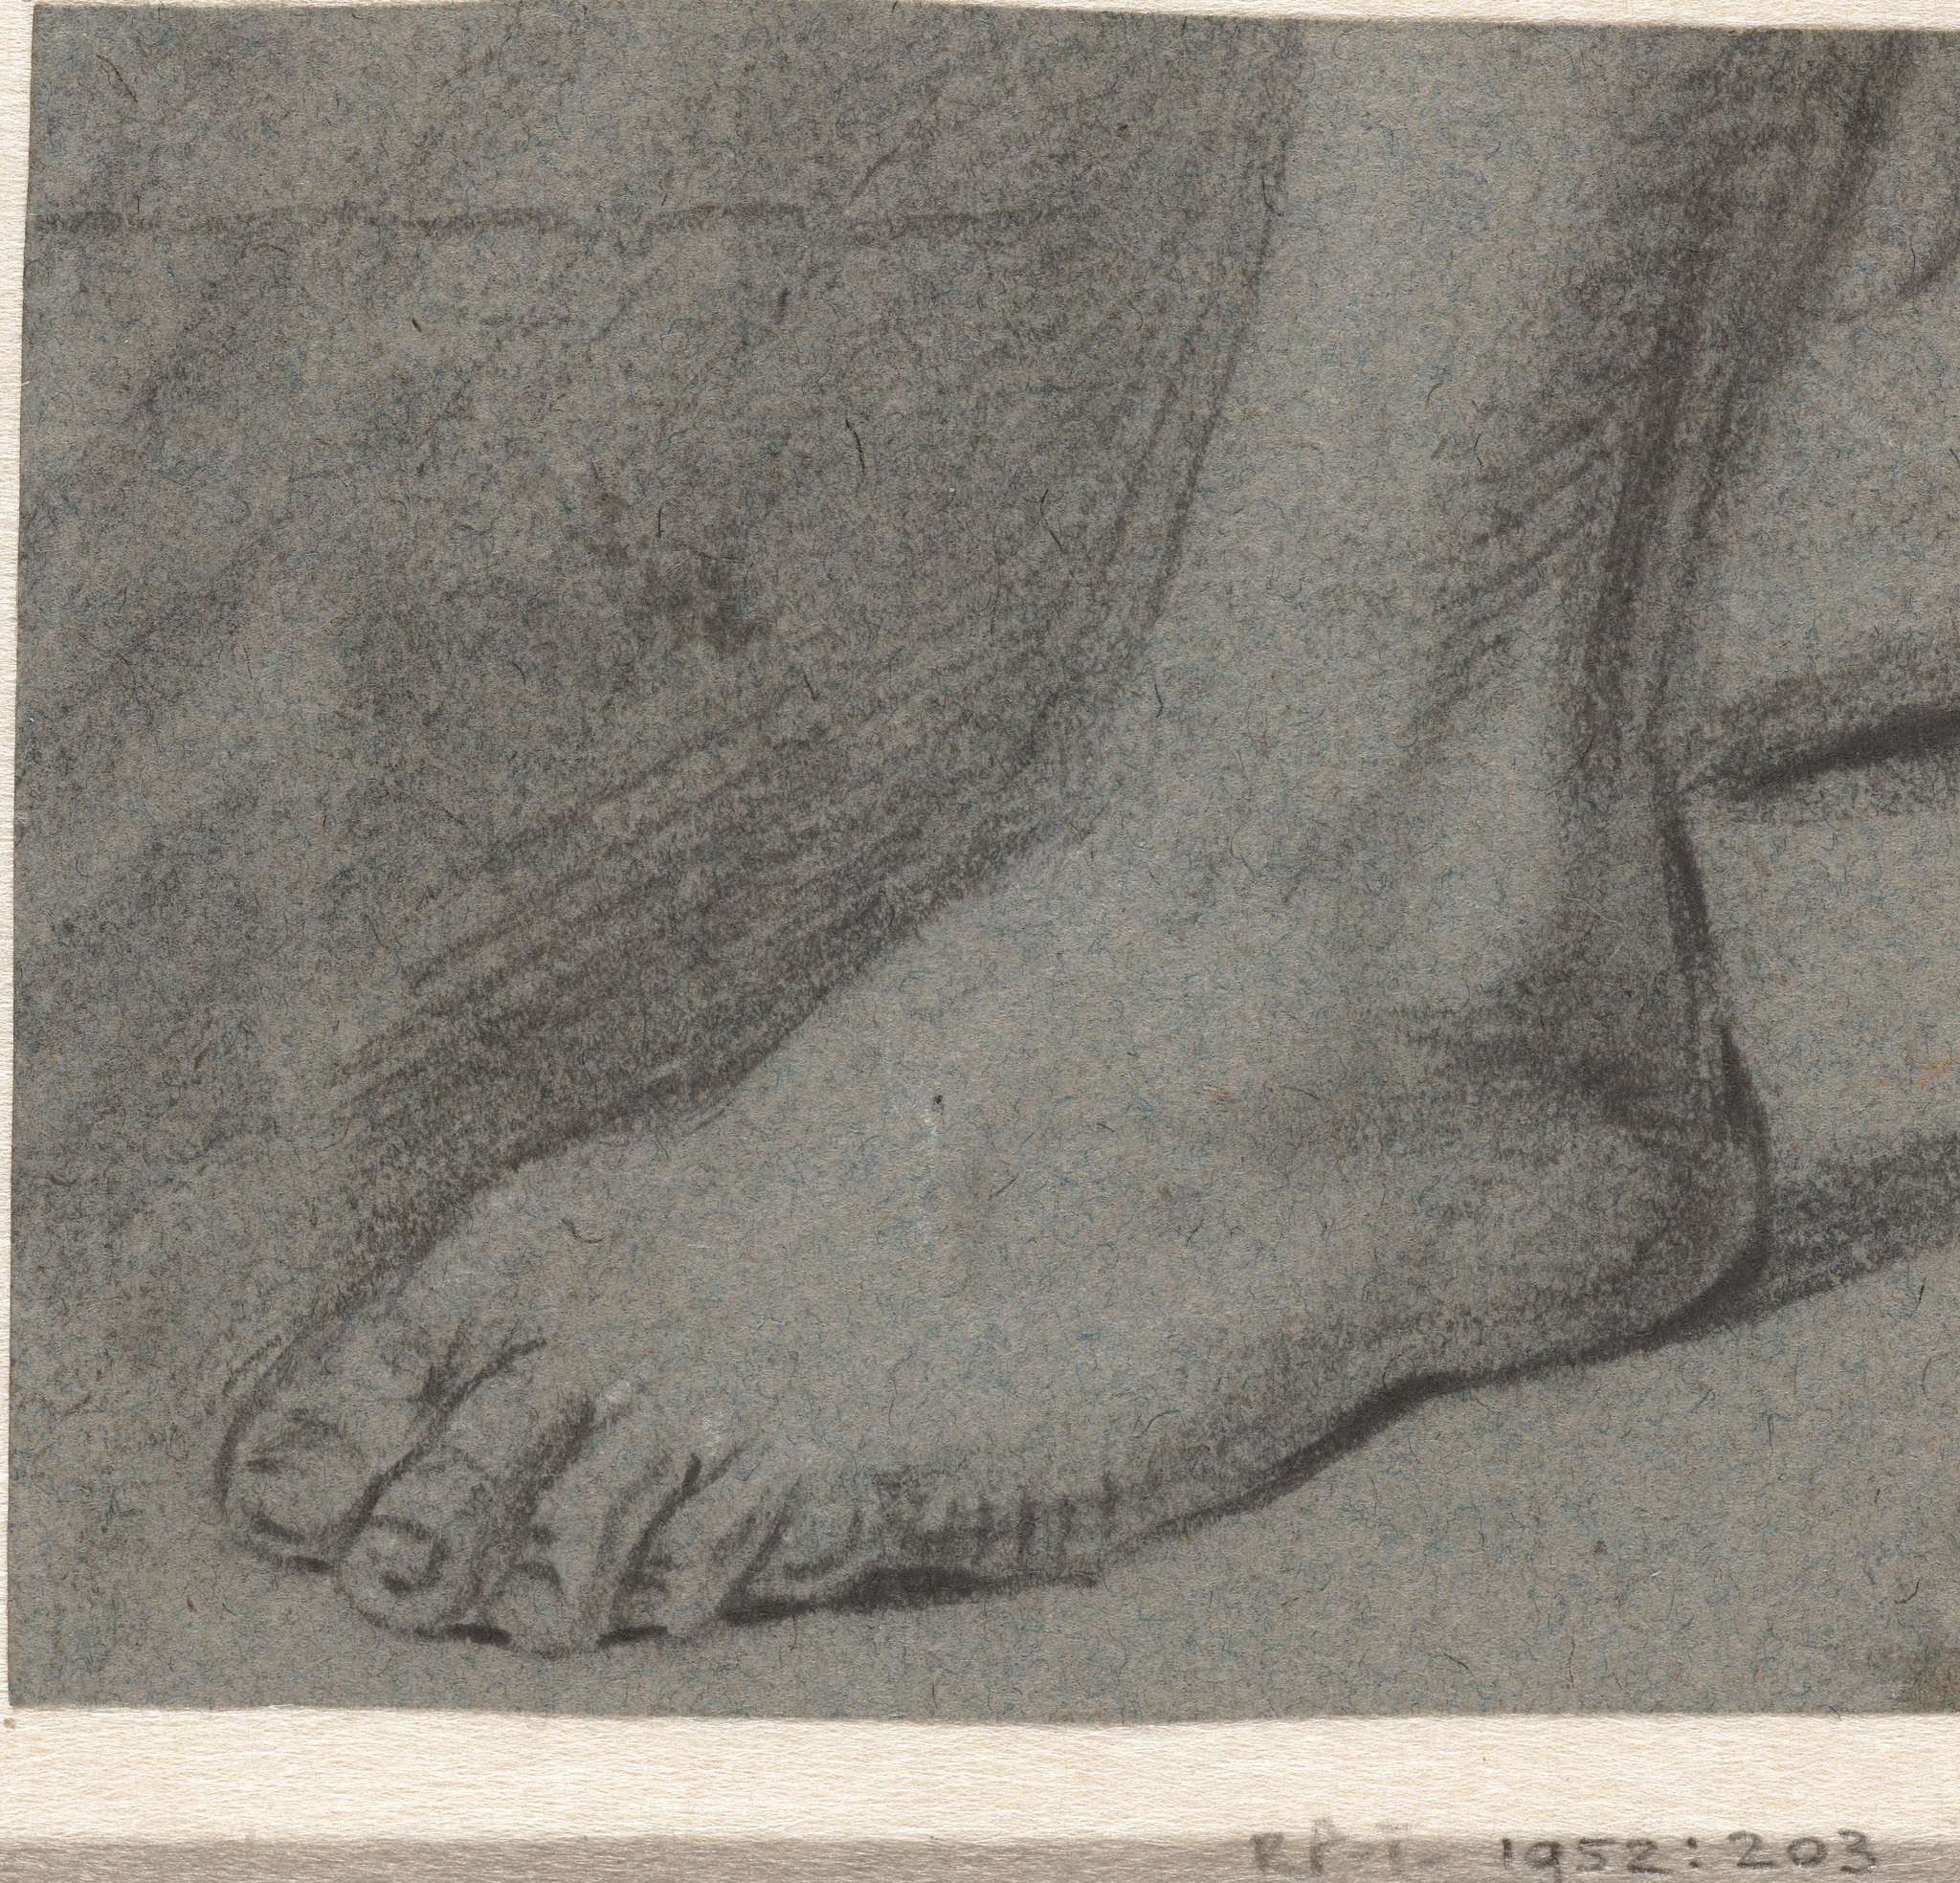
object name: drawing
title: Studie van een linkervoet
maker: simon andreas krausz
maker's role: draughtsman, print maker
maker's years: 1760-1825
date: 1770-1825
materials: chalk, paper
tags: foot